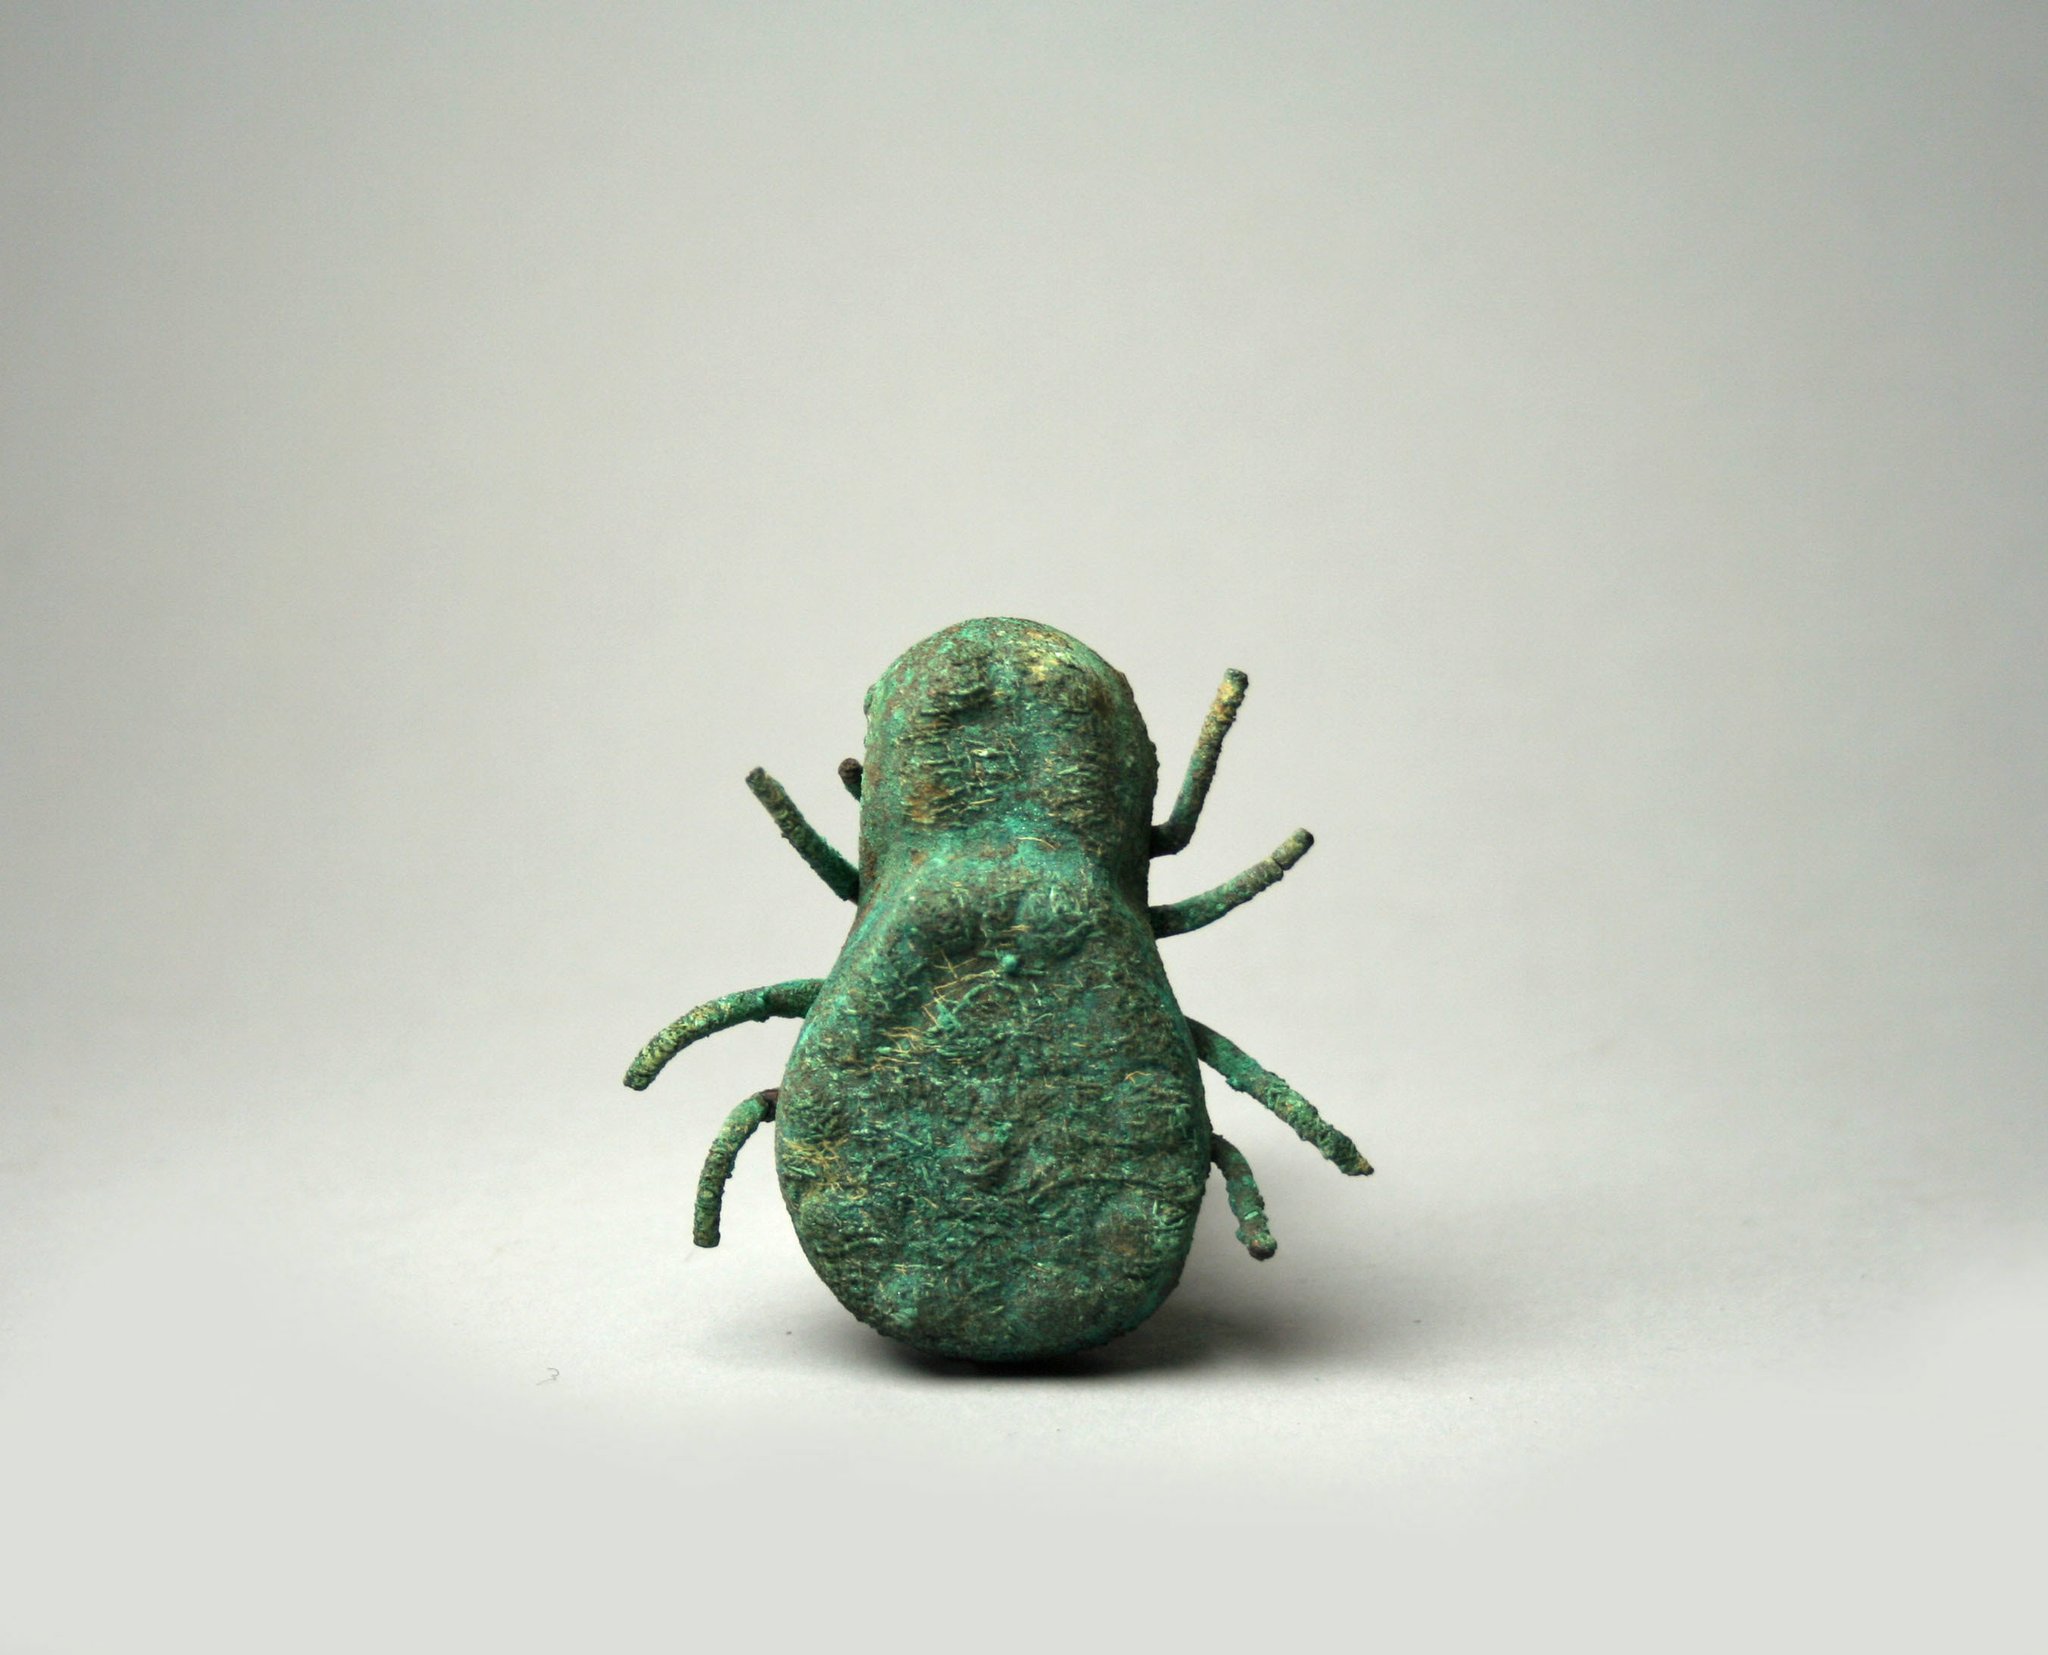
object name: ornament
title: Spider Ornament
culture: moche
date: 501-700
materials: gilt copper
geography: peru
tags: spiders